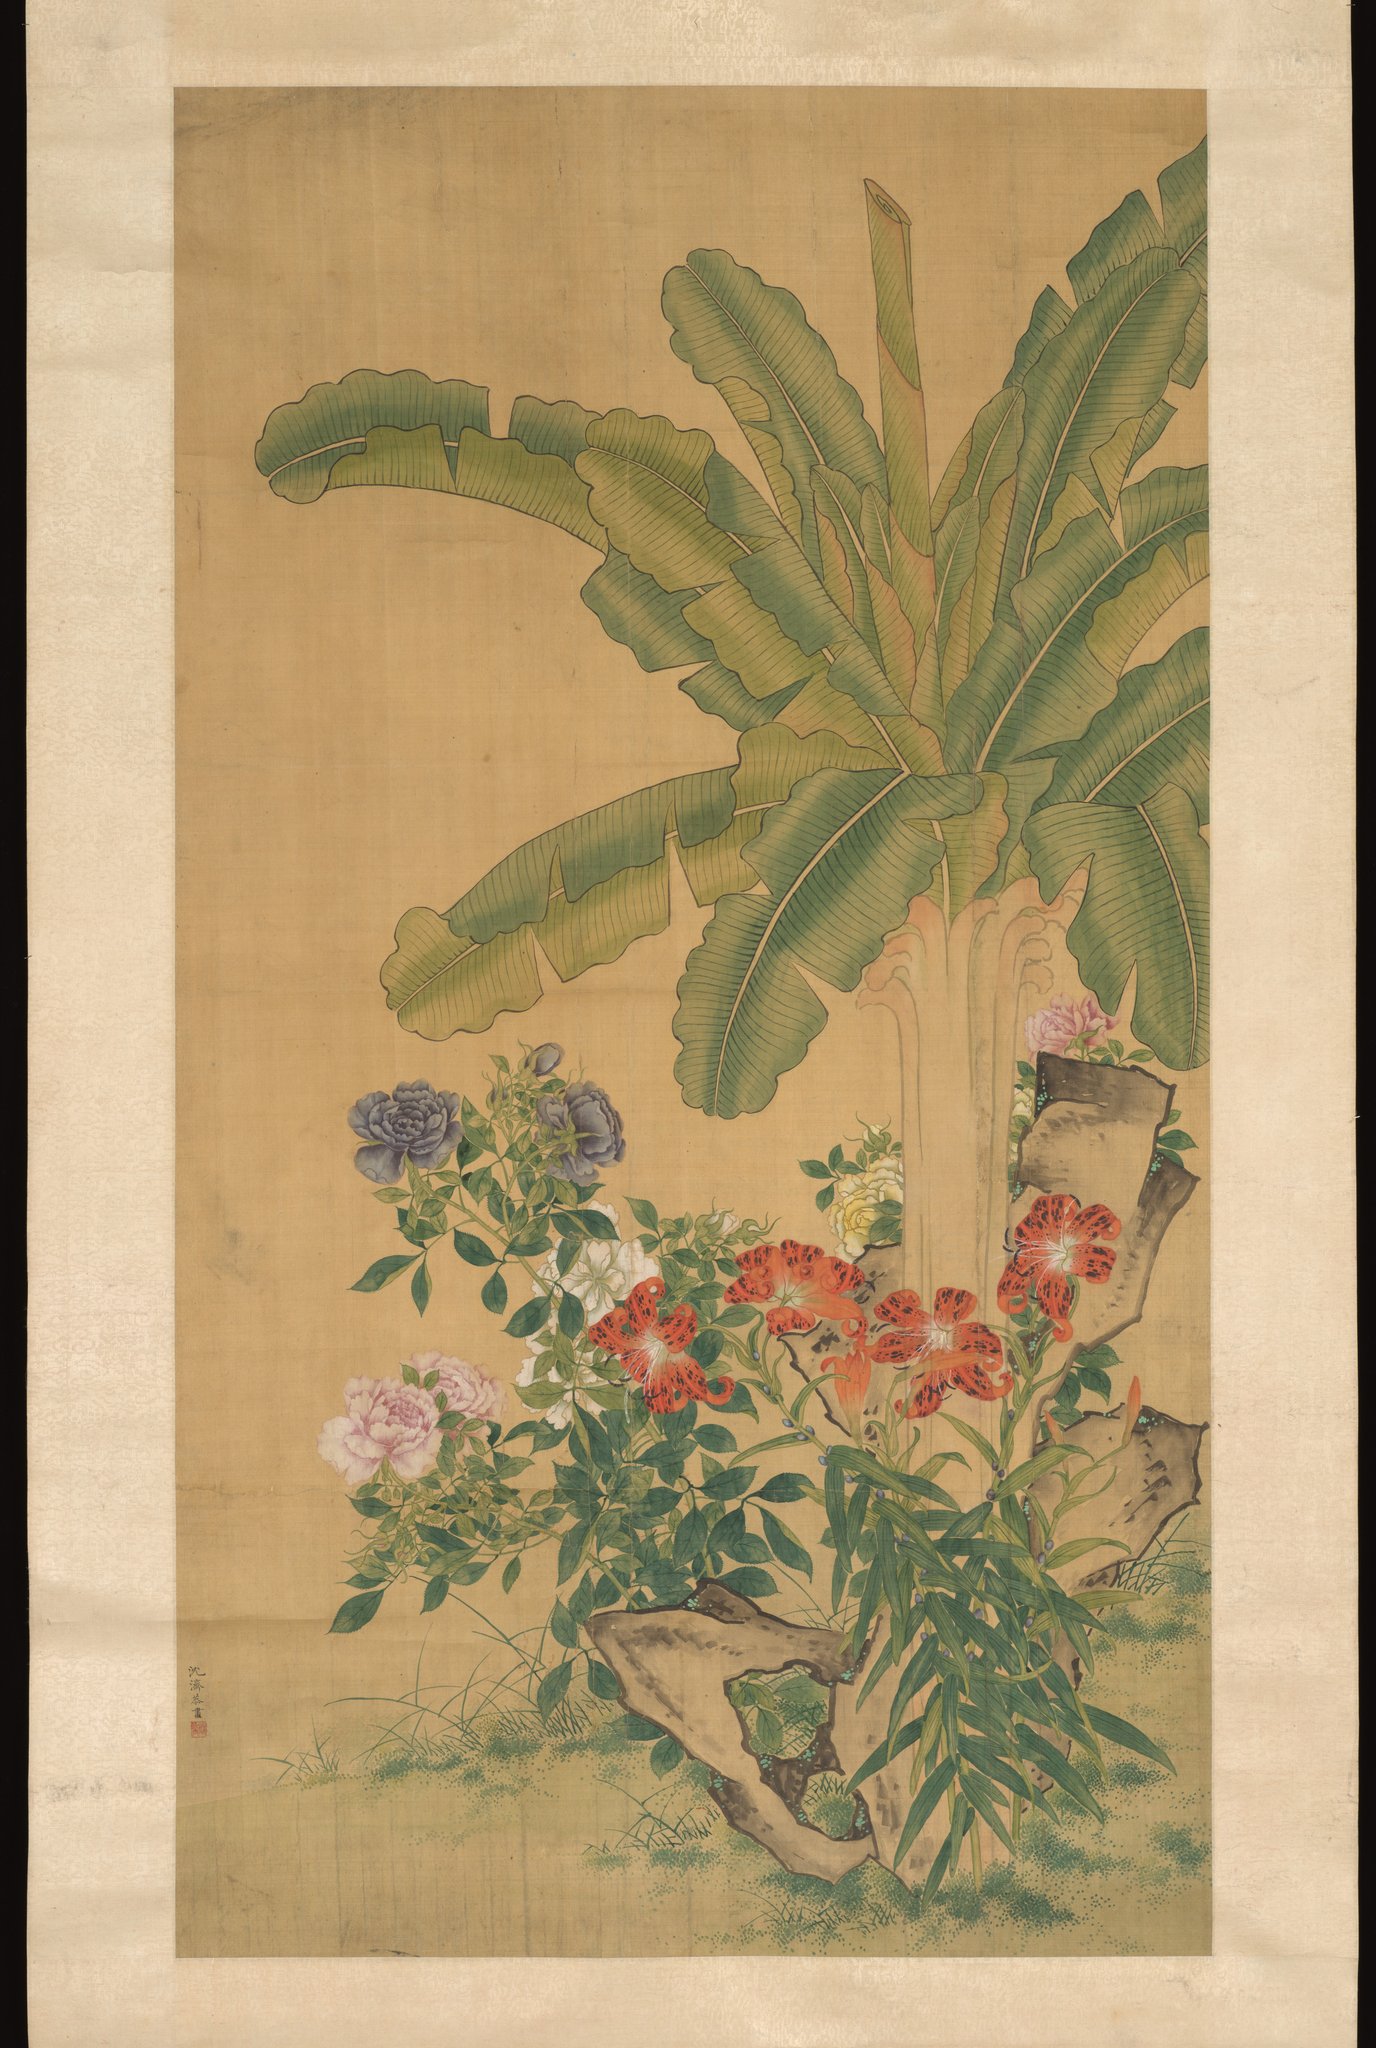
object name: hanging scroll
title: Bananas and Flowers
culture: chinese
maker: shen qi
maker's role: artist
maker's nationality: chinese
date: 1901-2000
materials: ink, silk